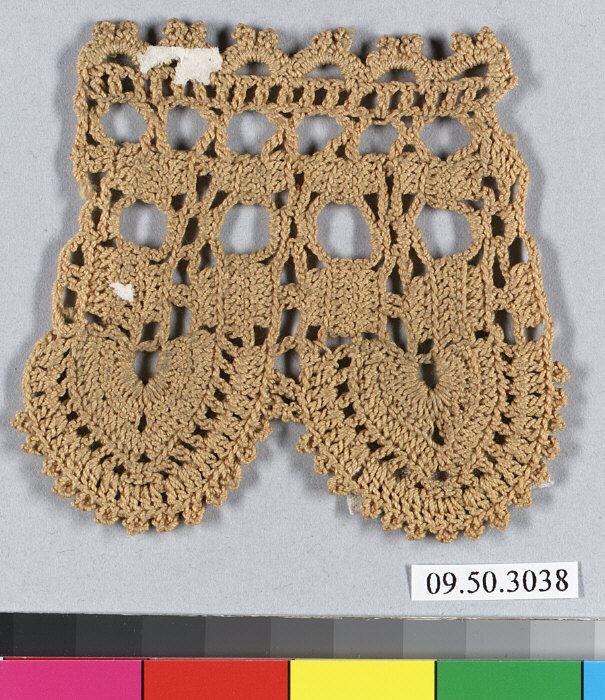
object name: sample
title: Crochet Work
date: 1801-1900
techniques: crochet